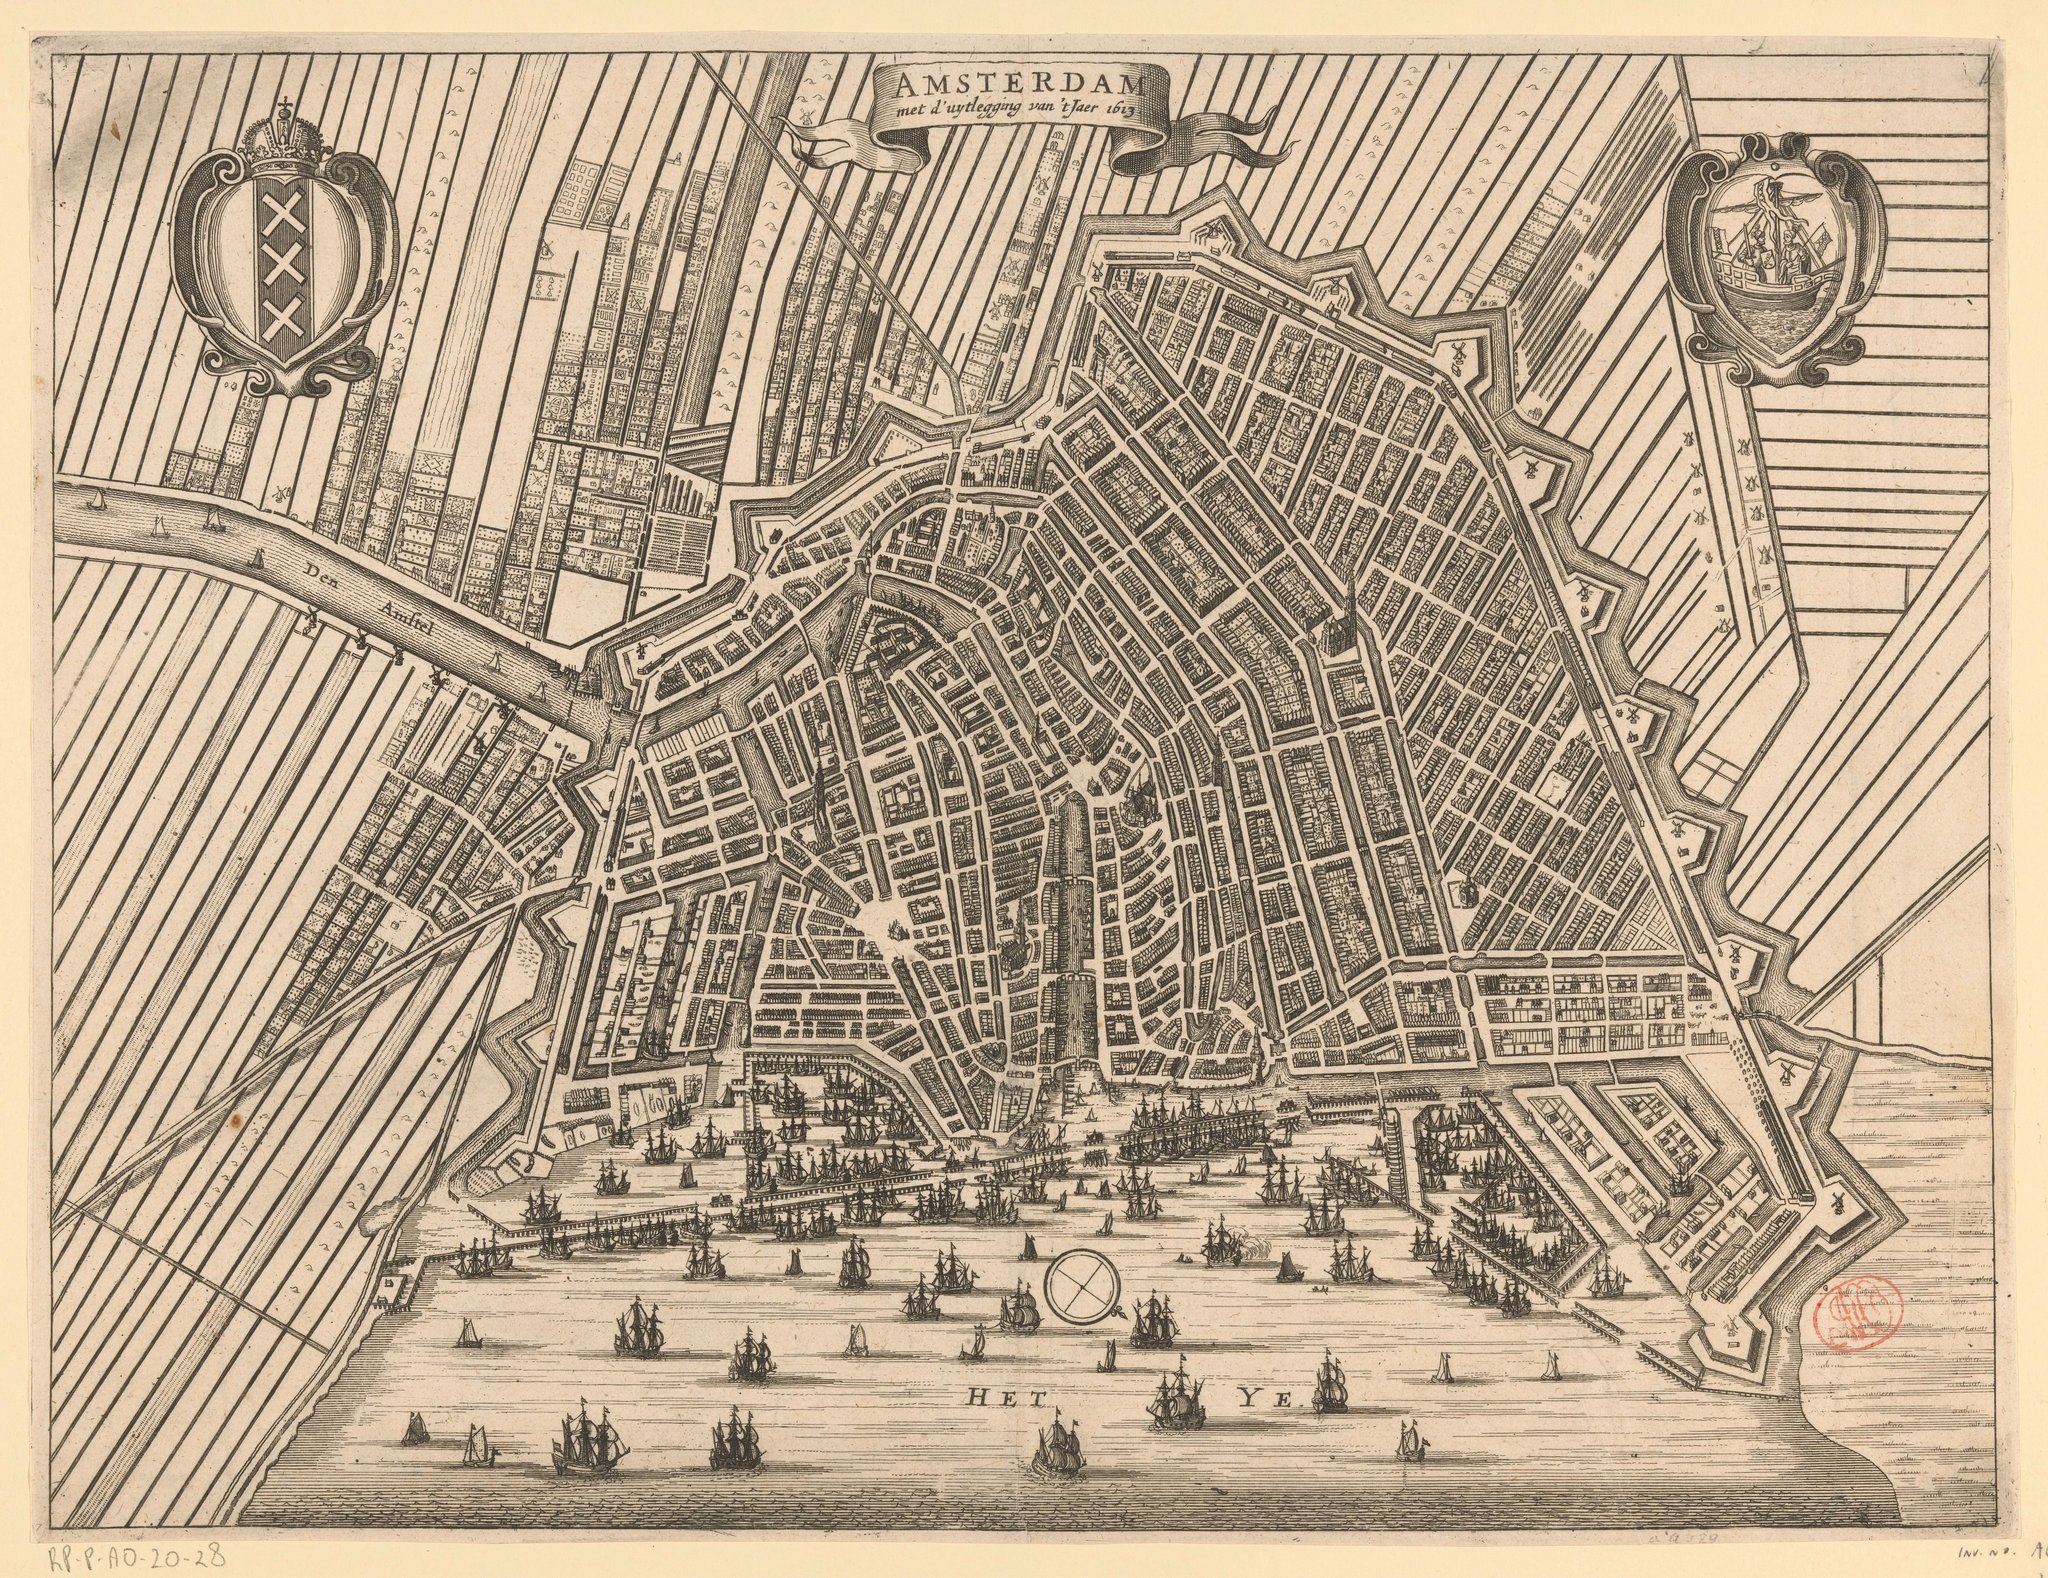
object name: book illustration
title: Amsterdam met d' uytlegging van 't Jaer 1613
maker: jacob van meurs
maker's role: draughtsman, print maker, publisher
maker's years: 1619-1680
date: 1663-1694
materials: paper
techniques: engraving, etching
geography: amsterdam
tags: coat of arms (as symbol of the state, etc.) (+ city; municipal), maps of cities, amsterdam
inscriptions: collector's mark: Lugt 195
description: Huidige staat van prent ook gebruikt in: Dapper, Olfert. Historische beschryving der stadt Amsterdam: waer in de voornaemste geschiedenissen (na een kort verhael van gansch Hollant en d'omleggende dorpen (…). Amsterdam: Jacob van Meurs, 1663. En in: Zesen, Philipp von. Beschreibung der Stadt Amsterdam: darinnen von derselben ersten Ursprunge bis auf gegenwärtigen Zustand (…). Amsterdam: Joachim Nosche, 1664. En in: Commelin, Caspar. Beschryvinge van Amsterdam, desselfs eerste oorspronk uyt den Huyse (…). 2 delen. Amsterdam: Abraham Wolfgang, Gillis Janssonius van Waesberge, Johannes Janssonius van Waesberge II, weduwe Dirk Boom I, Hendrick Boom en Rembertus Goethals, 1693. En in: Commelin, Caspar. Beschryvinge van Amsterdam, zynde een naukeurige verhandelinge van desselfs eerste oorspronk uyt (…). 2 delen. Amsterdam: weduwe Aart Dircksz Oossaan, 1694.